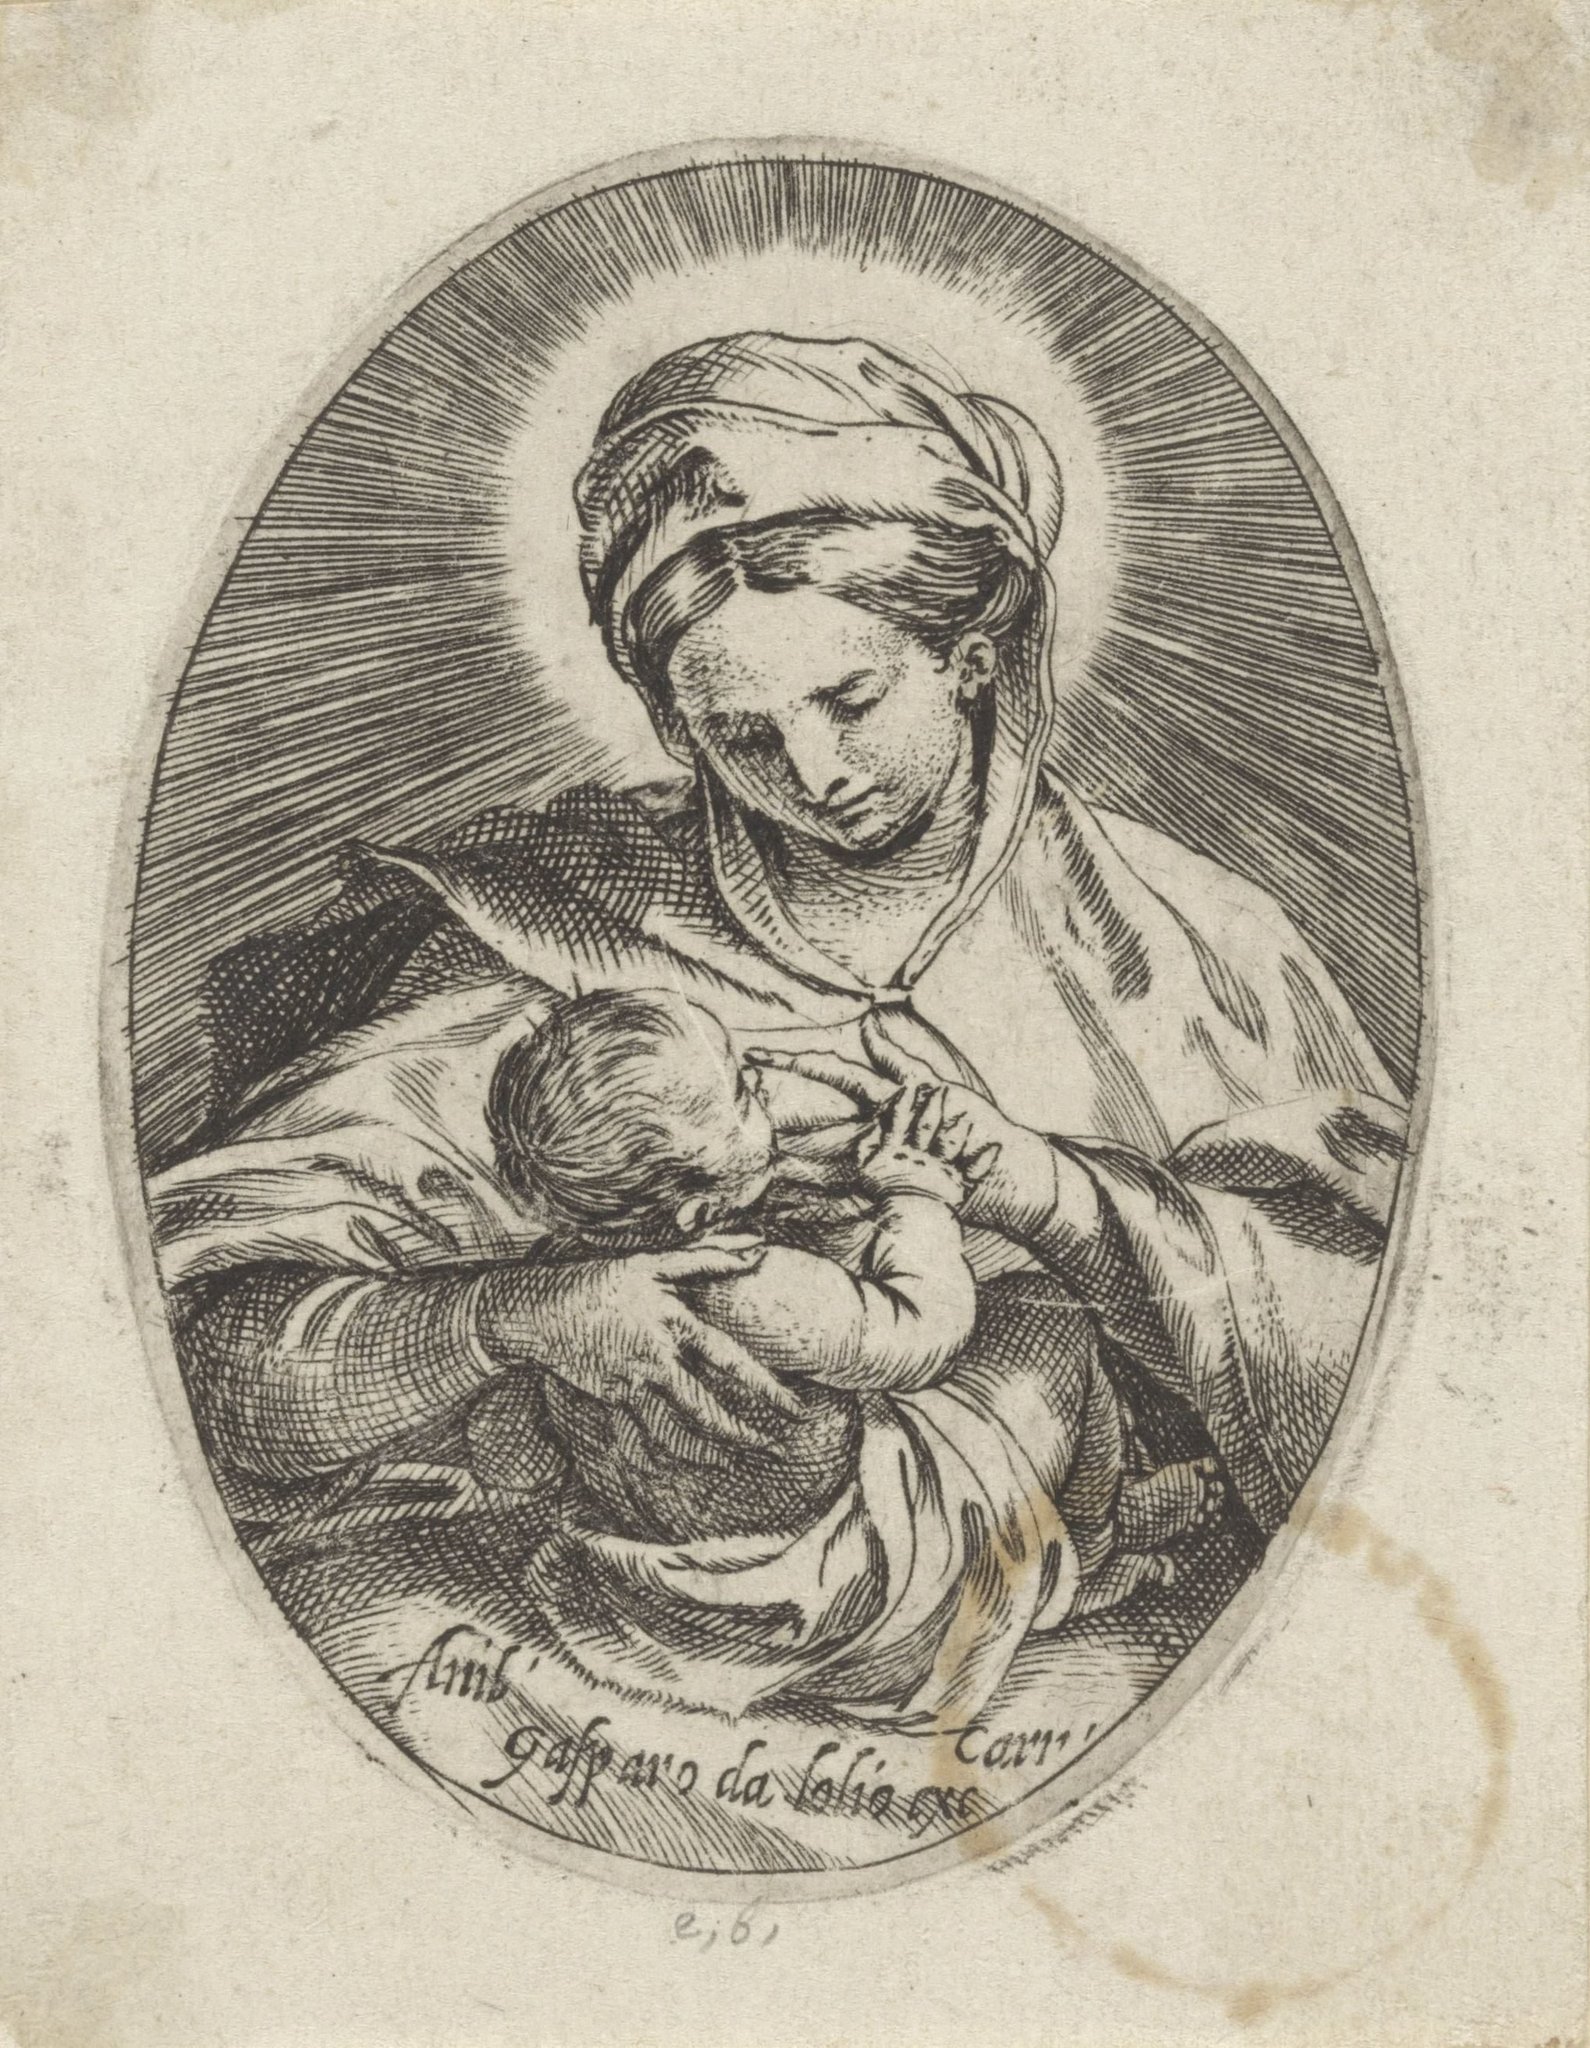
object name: print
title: Maria het Kind voedend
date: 1583-1587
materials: paper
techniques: engraving, etching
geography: italy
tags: mary giving milk from her breasts, 'lactatio'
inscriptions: collector's mark: Lugt 240